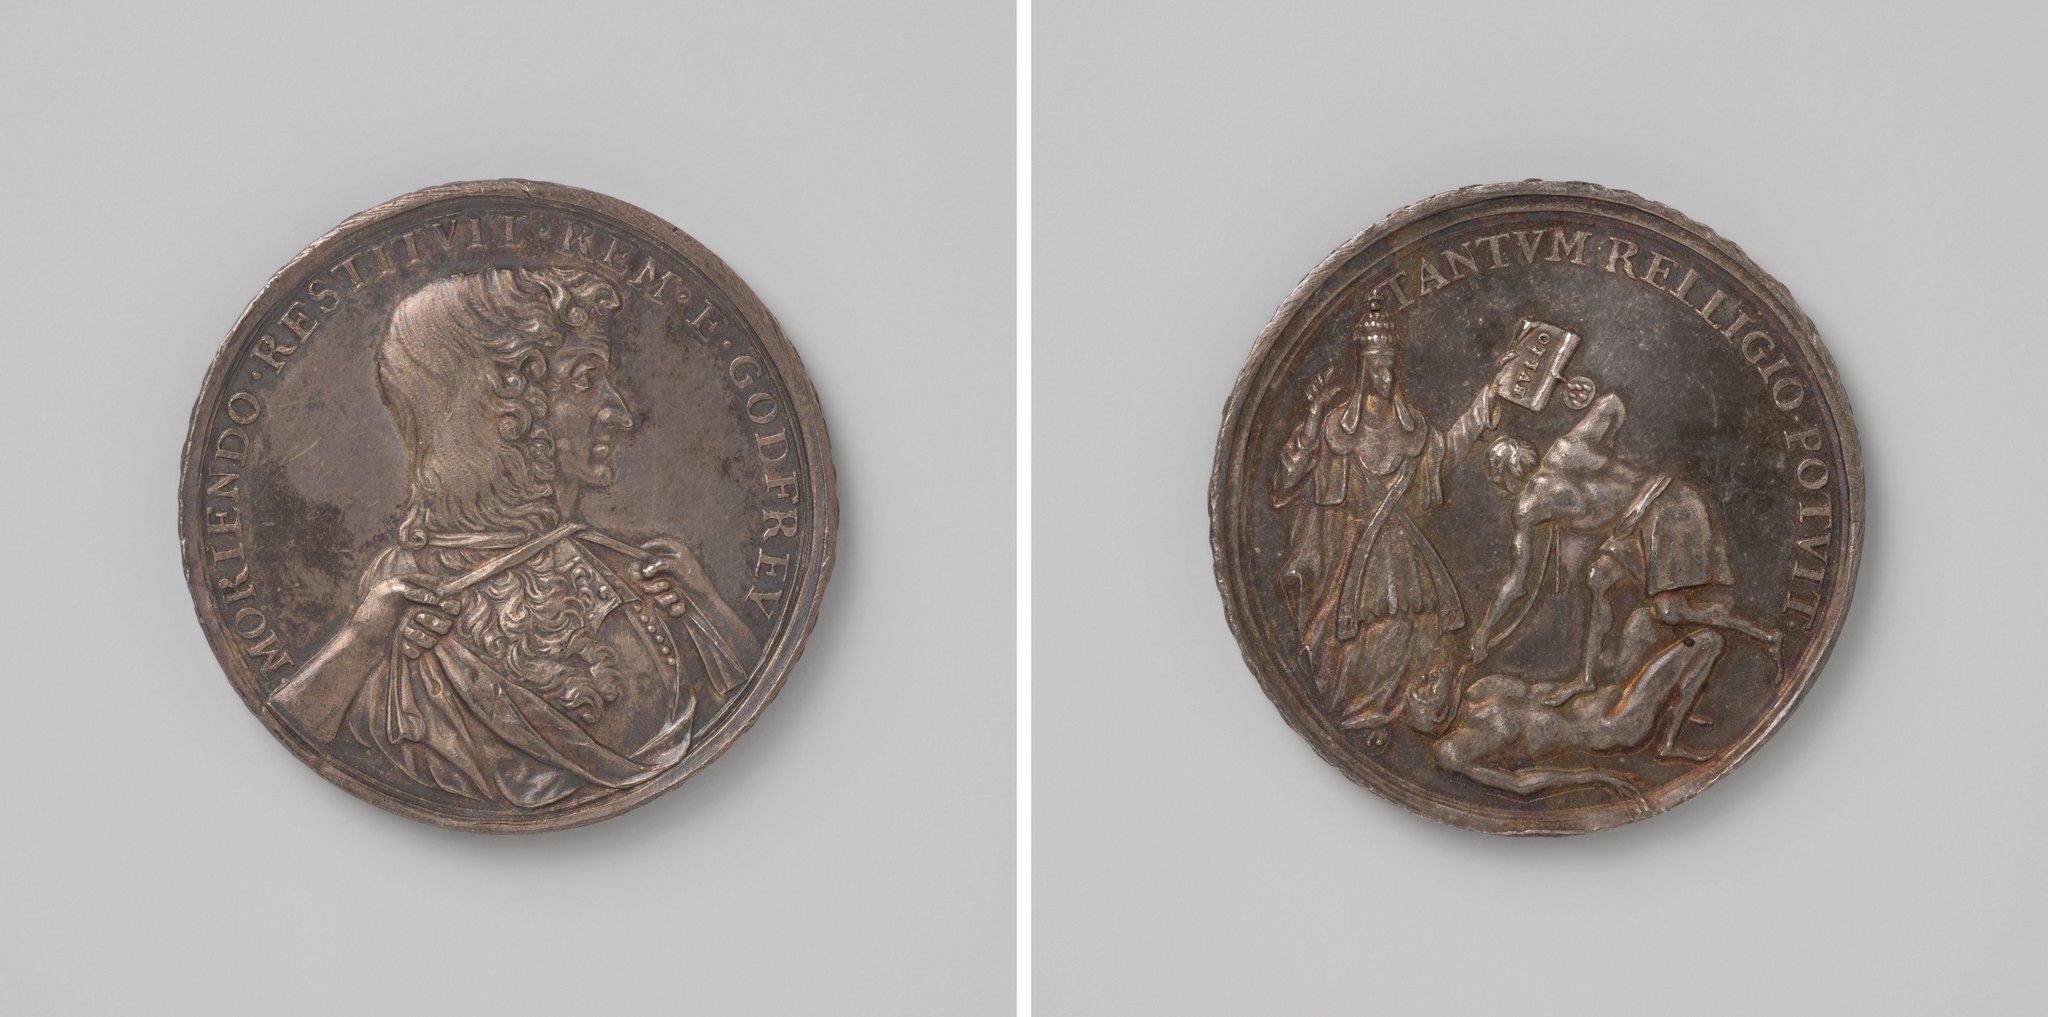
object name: history medal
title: Moord op sir Edmund Berry Godfrey, vrederechter in Engeland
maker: george bower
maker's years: 1650-1690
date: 1678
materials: silver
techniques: striking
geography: london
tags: england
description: Zilveren penning. Voorzijde: borststuk man, die door twee handen met zijn eigen das wordt gewurgd binnen omschrift. Keerzijde: Godfrey wordt gewurgd terwijl paus met bul in de hand moordenaar zegent binnen omschrift; randschrift